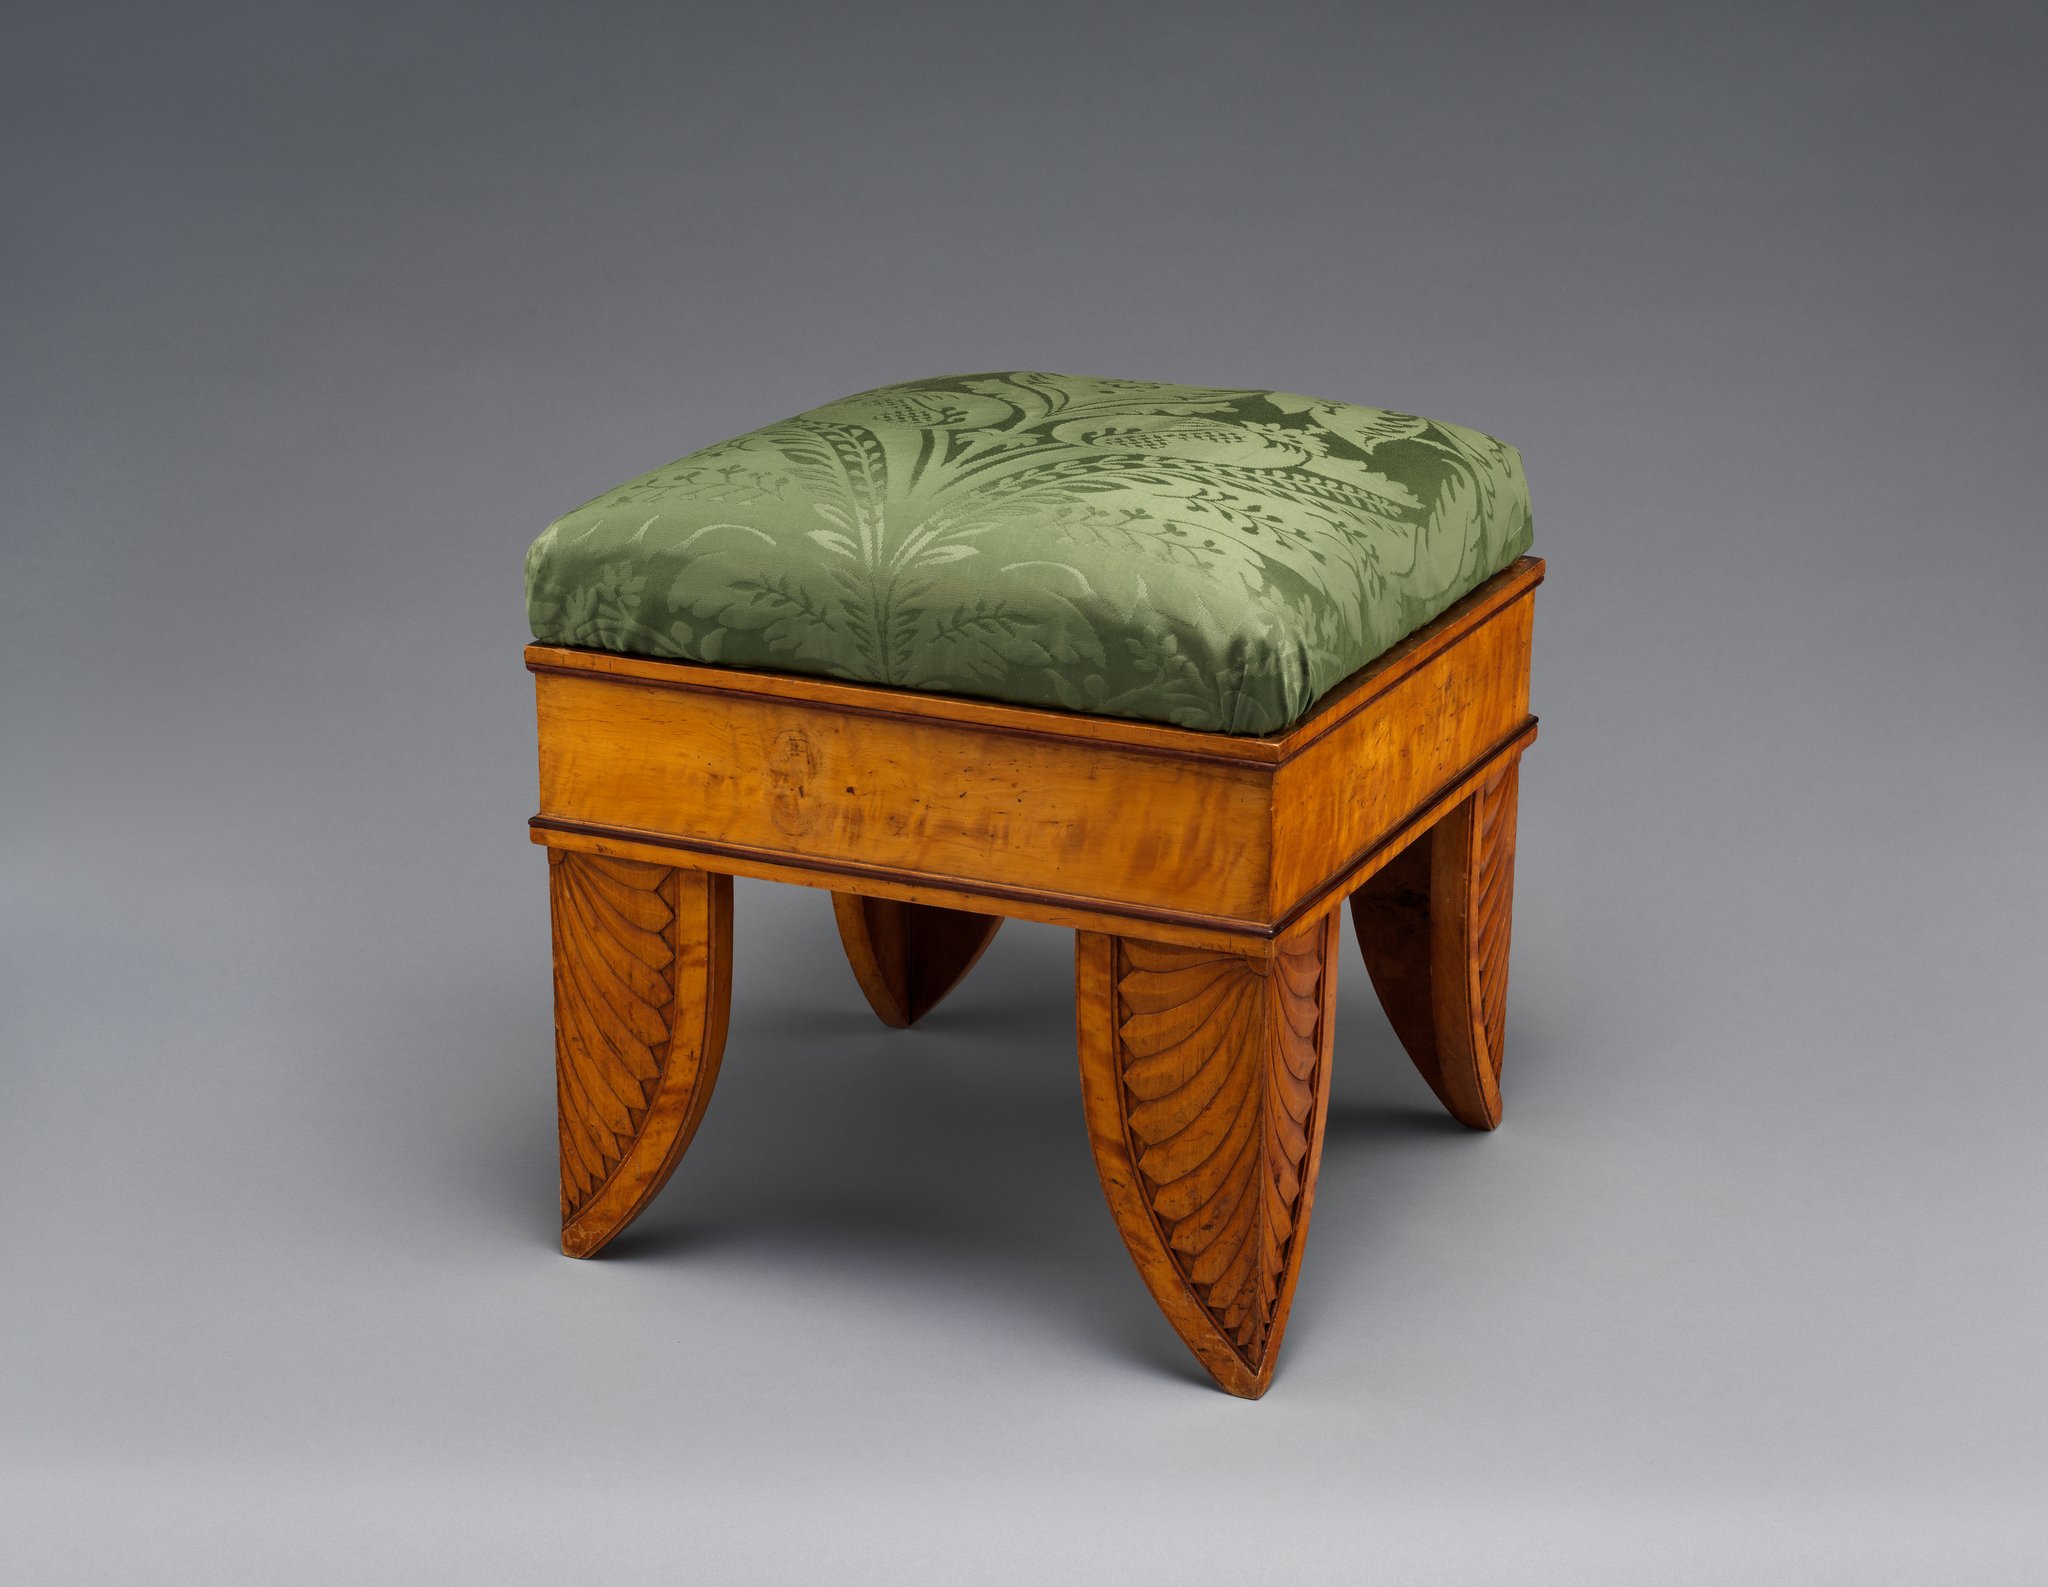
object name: stool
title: Stool (tabouret)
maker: friedrich gilly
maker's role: designer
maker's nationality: german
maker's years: 1772-1800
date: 1805-1810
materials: wood, silk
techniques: lampas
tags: flowers,leaves,stools